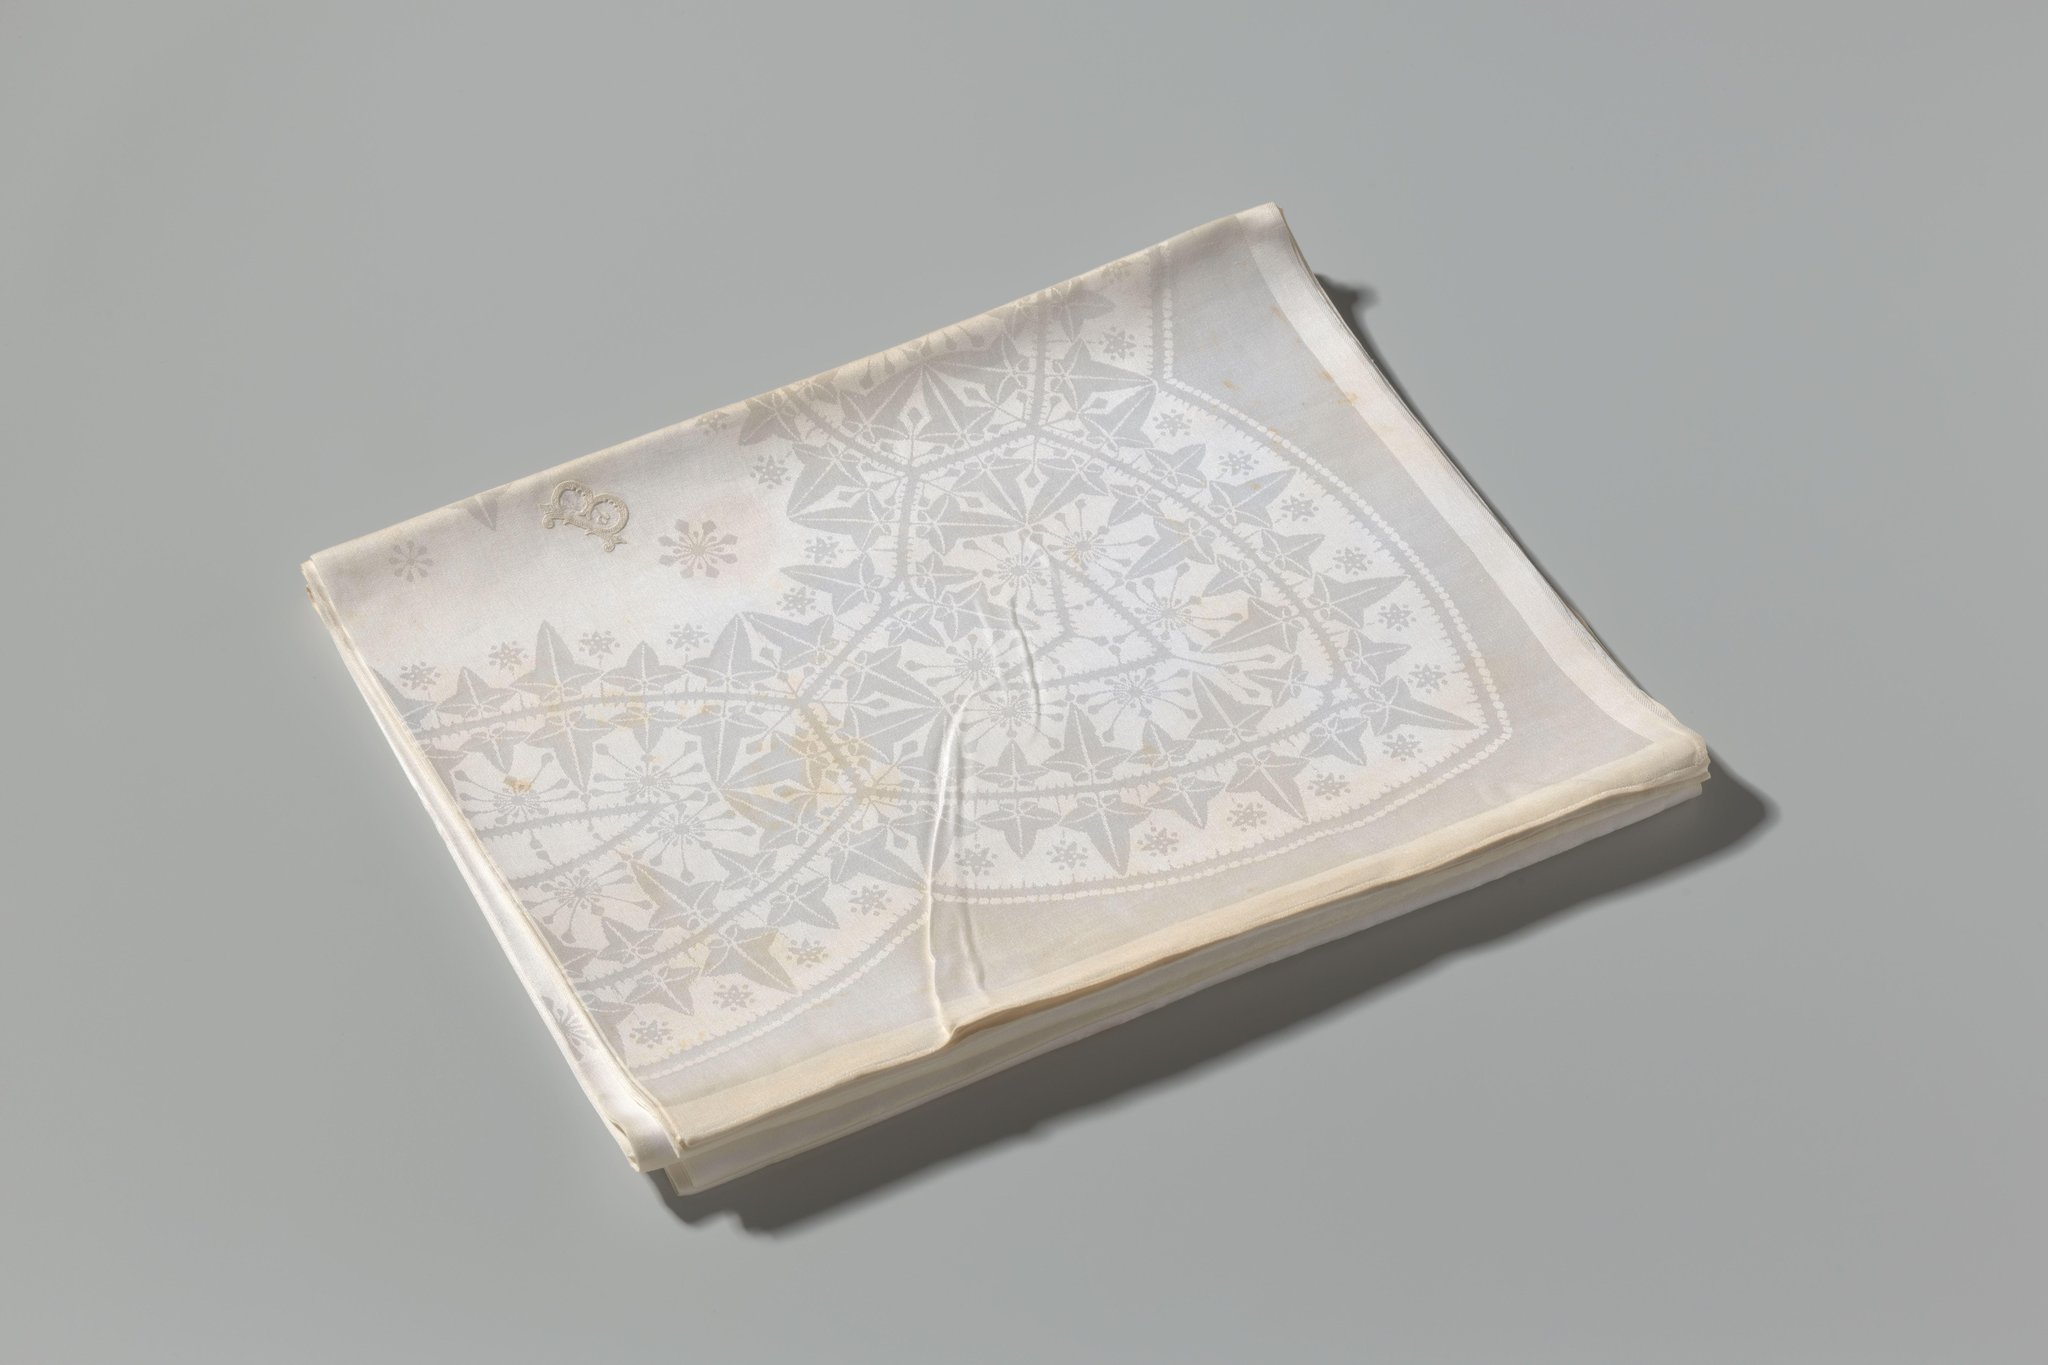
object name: tablecloth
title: Tafellaken van linnendamast met klimop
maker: chris lebeau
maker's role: draughtsman, print maker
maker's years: 1878-1945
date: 1904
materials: linen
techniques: damask, weave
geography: eindhoven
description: Tafellaken van linnendamast met klimop: motief Klimop, dessin nr. 513. Het tafellaken hoort bij een tafellaken (BK-1979-261-B) en twaalf servetten (BK-1979-262-A t/m BK-1979-262-L).